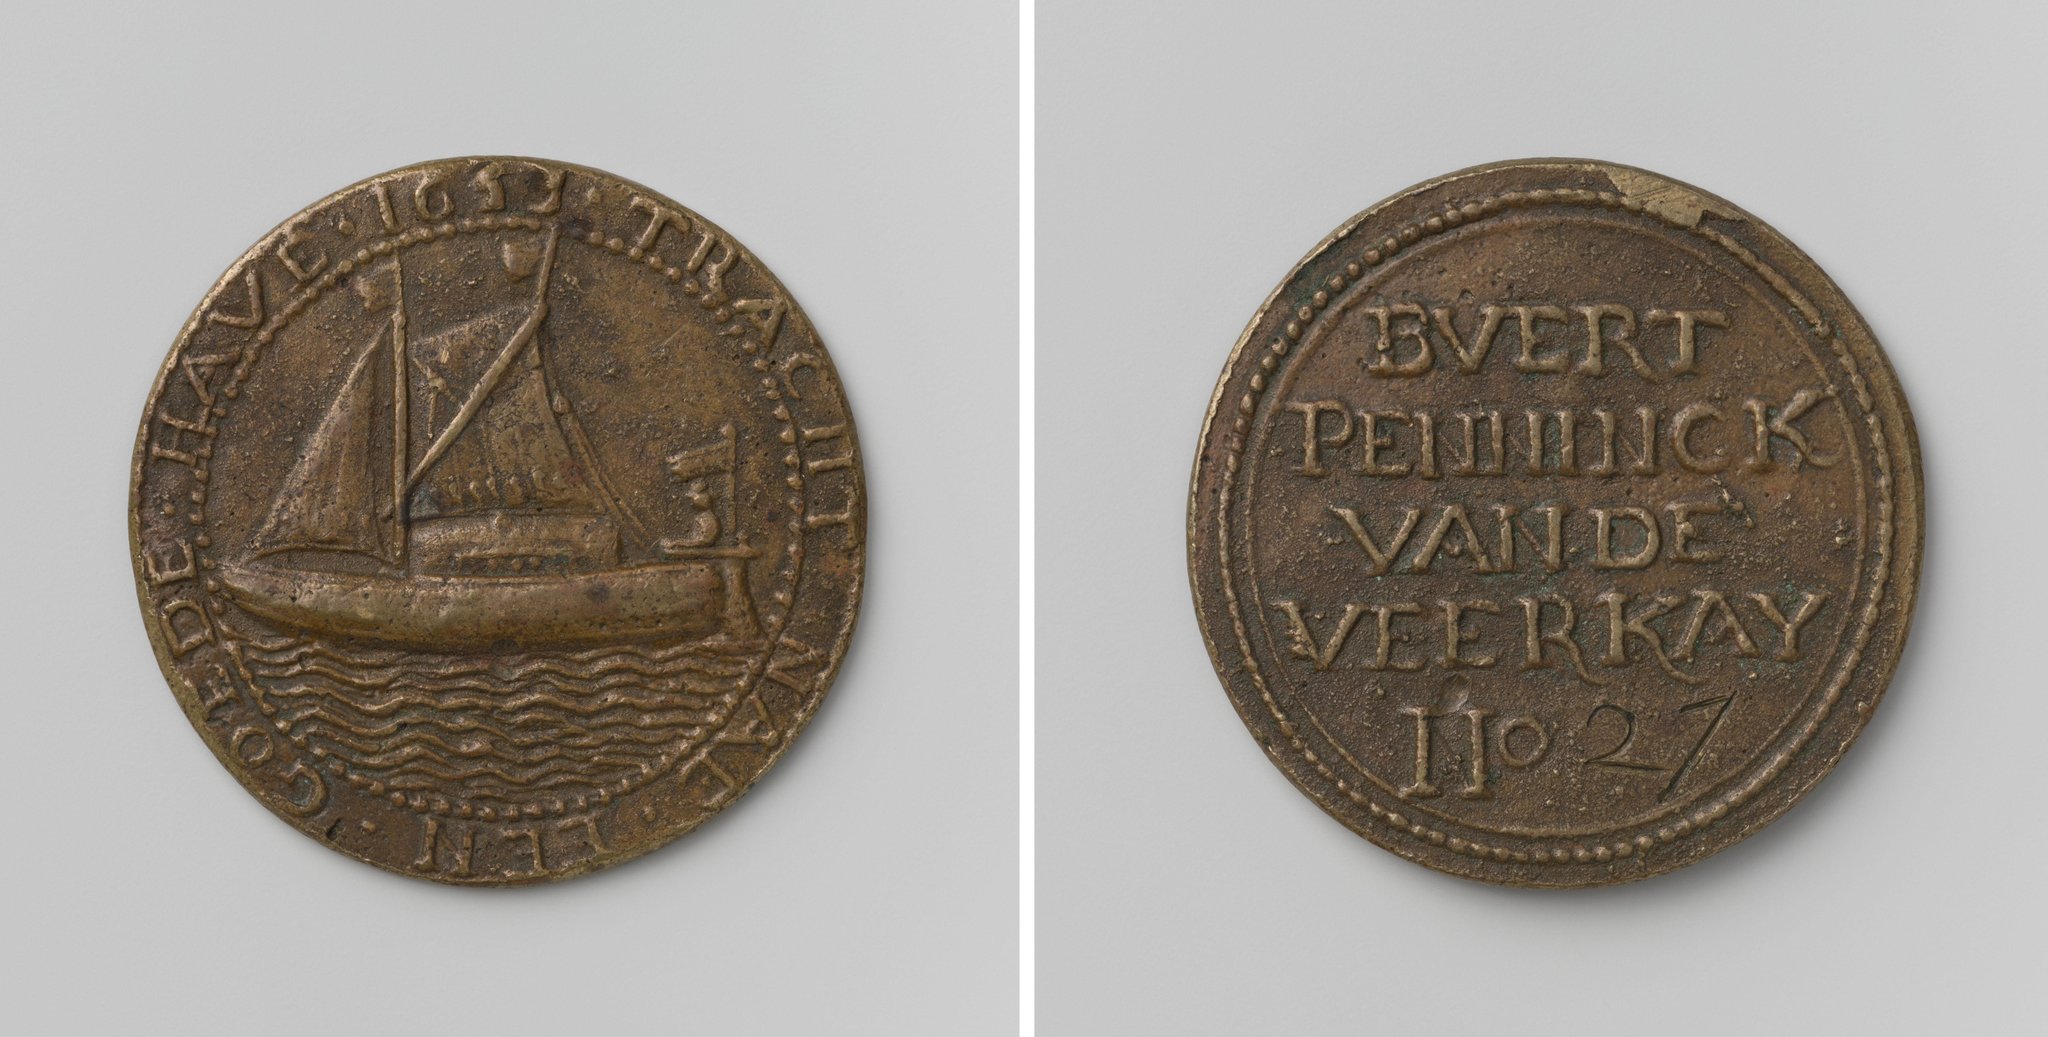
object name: buurtpenning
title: Buurt van de Veerkade te 's-Gravenhage, buurtpenning met no. 27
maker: Anonymous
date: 1653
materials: brass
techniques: casting, engraving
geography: the hague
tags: veerkade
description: Messing penning. Voorzijde: naar links varend schip; op achtersteven: man onder vlag binnen omschrift. Keerzijde: opschrift boven cijfer no. 27